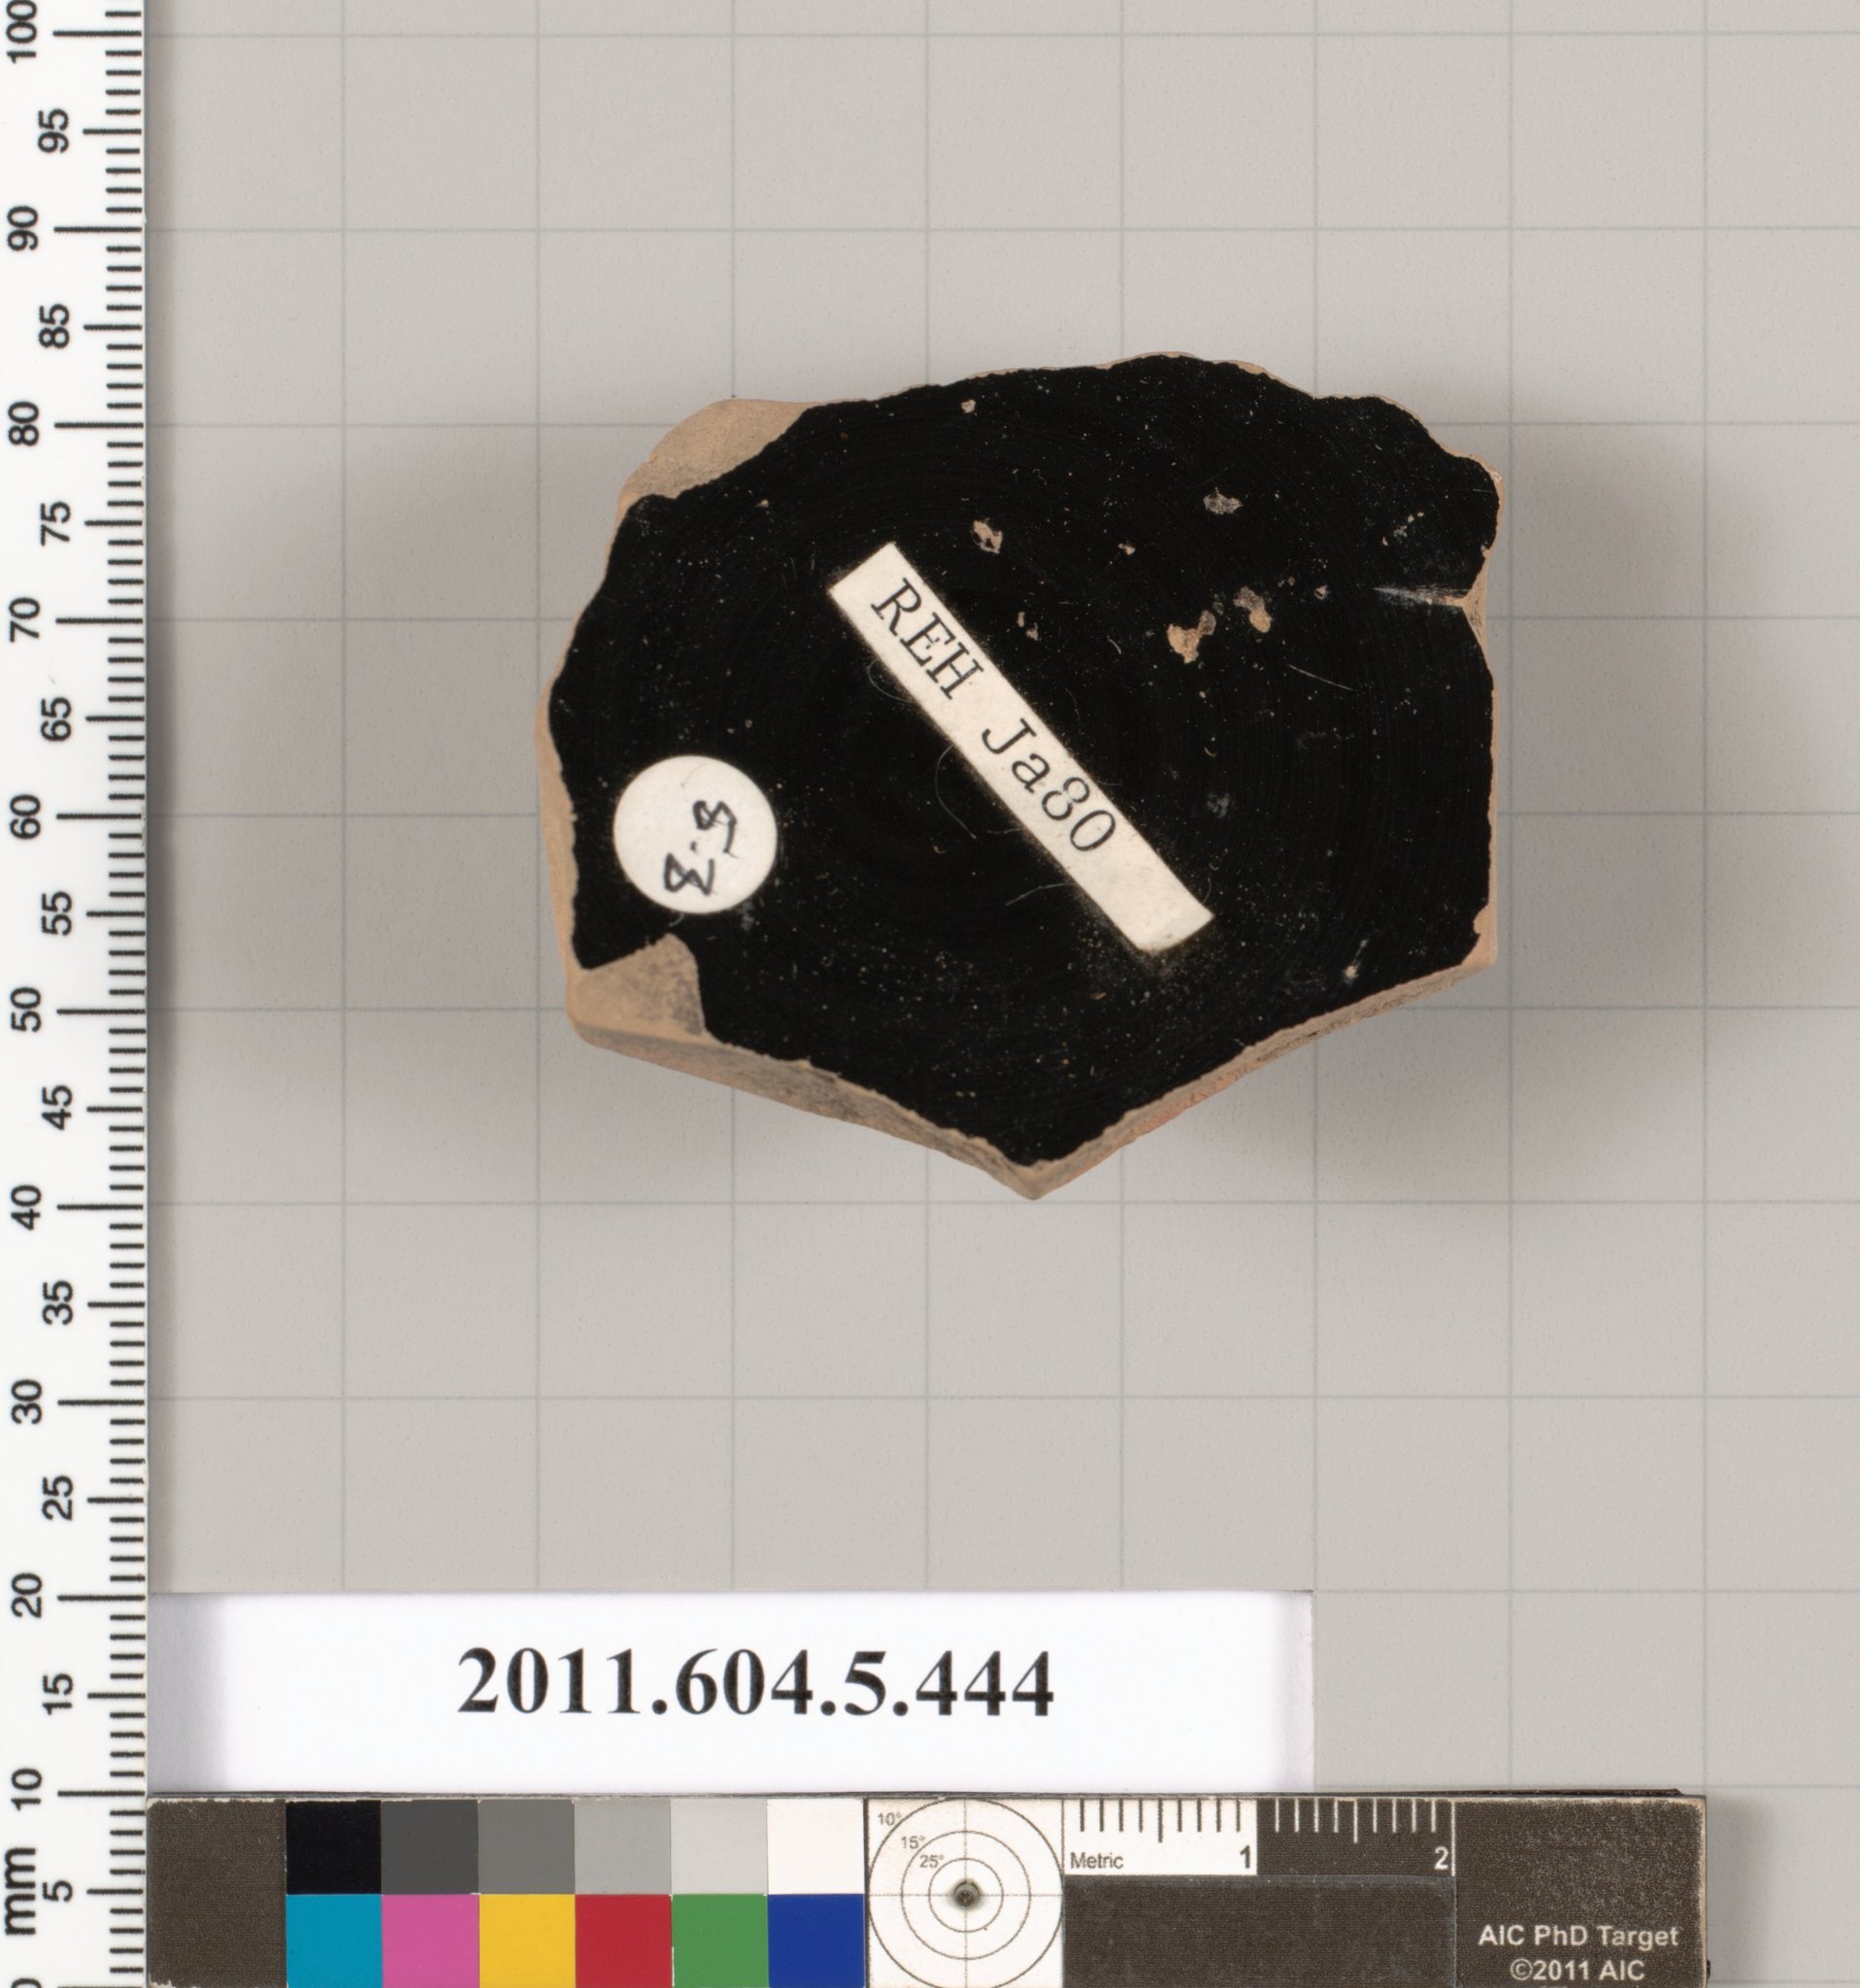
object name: kylix fragment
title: Terracotta fragment of a kylix (drinking cup)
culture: greek, attic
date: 600-401 BCE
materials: terracotta